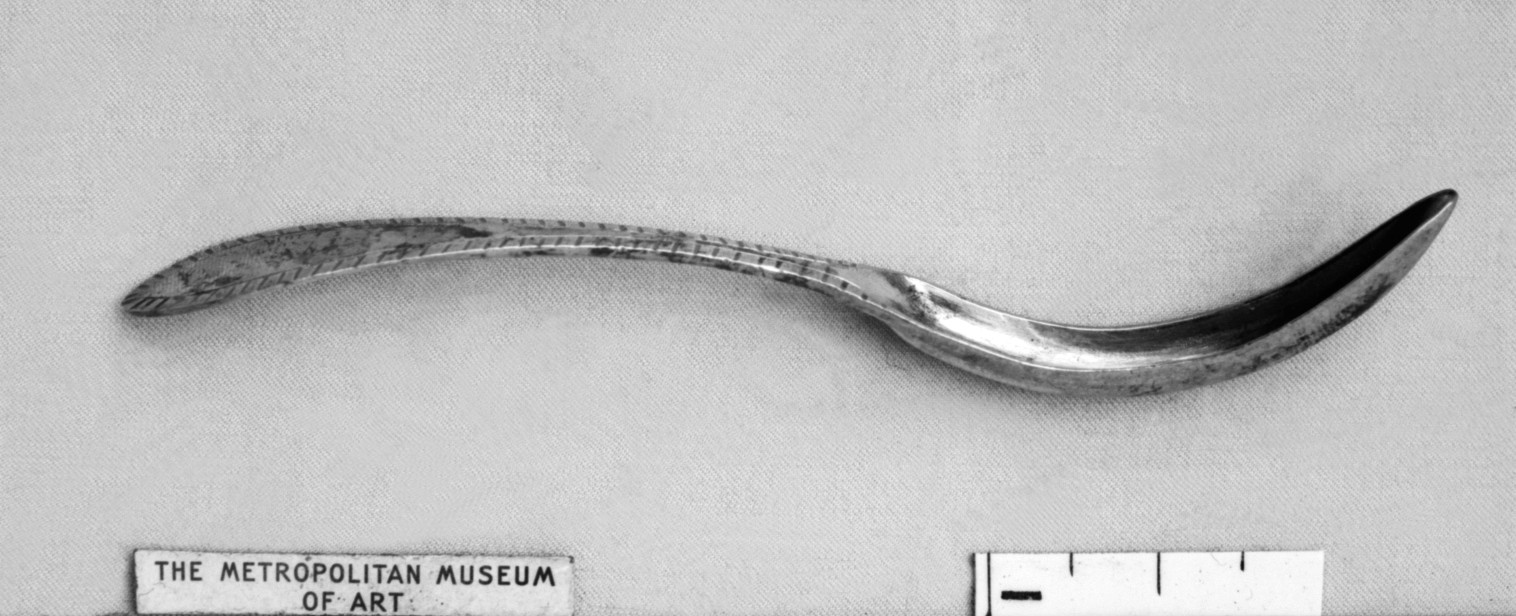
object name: marrow spoon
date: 1801-1900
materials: gilt, silver